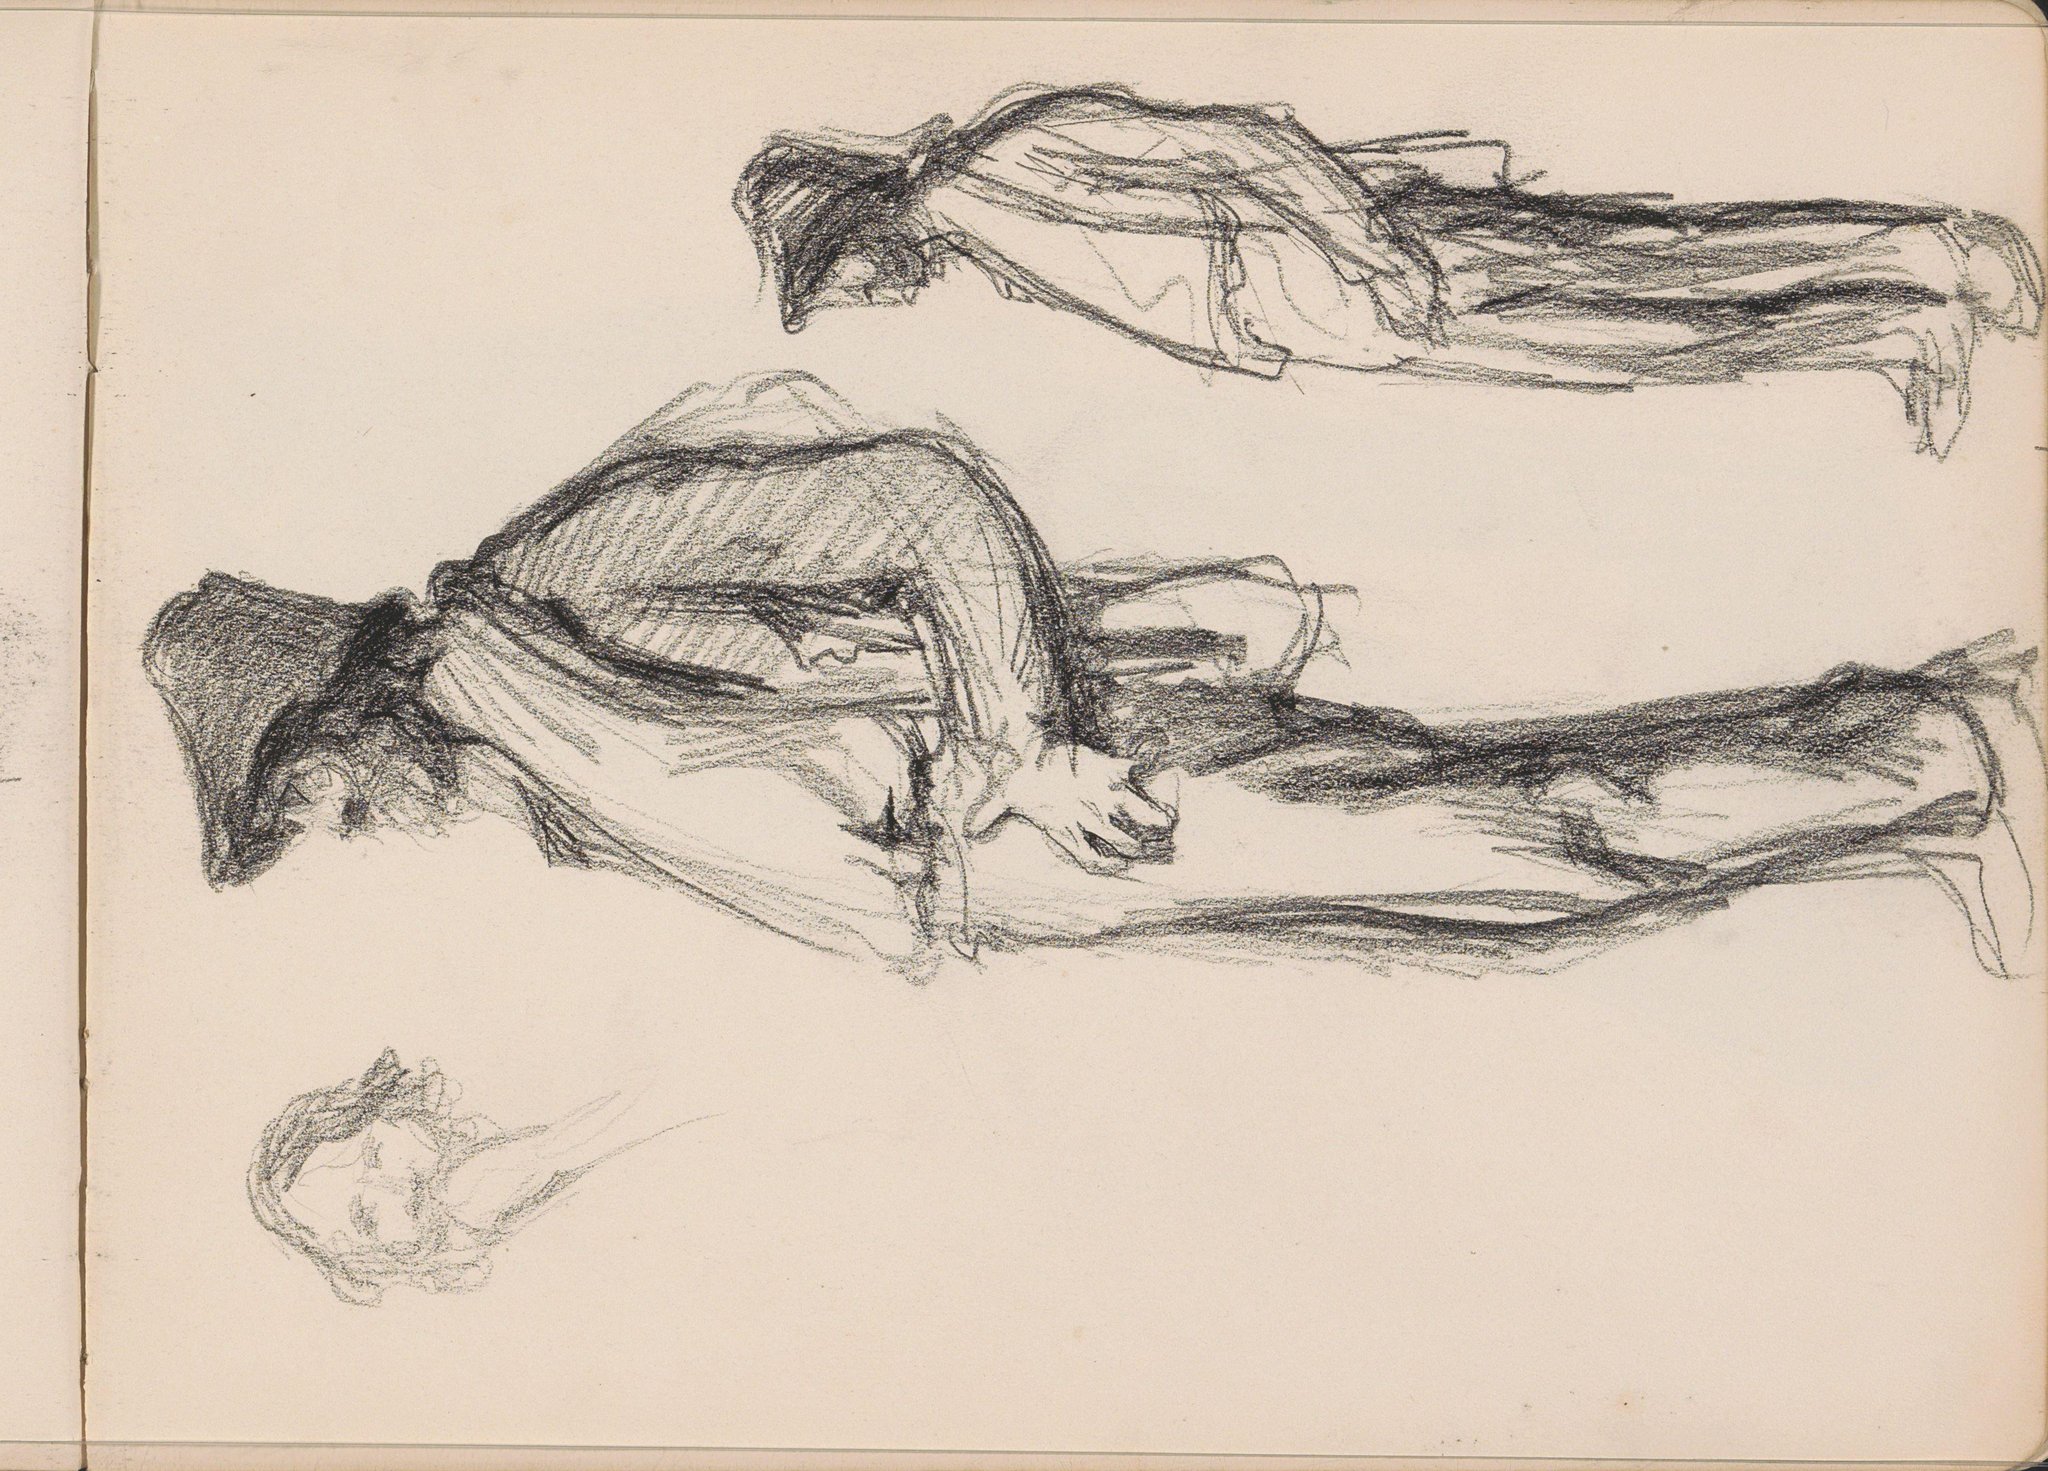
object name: sketchbook leaf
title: Staande man met een hoed, van opzij gezien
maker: a.a.l. de grammont-hubrecht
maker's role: draughtsman, painter, print maker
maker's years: 1855-1913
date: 1865-1913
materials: chalk, paper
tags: head (human), standing figure, hand on the hip, adult man, head-gear: hat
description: De man heeft de handen op de heupen. Tevens een studie van een mannenkop. Blad 20 recto uit een schetsboek met 39 bladen.